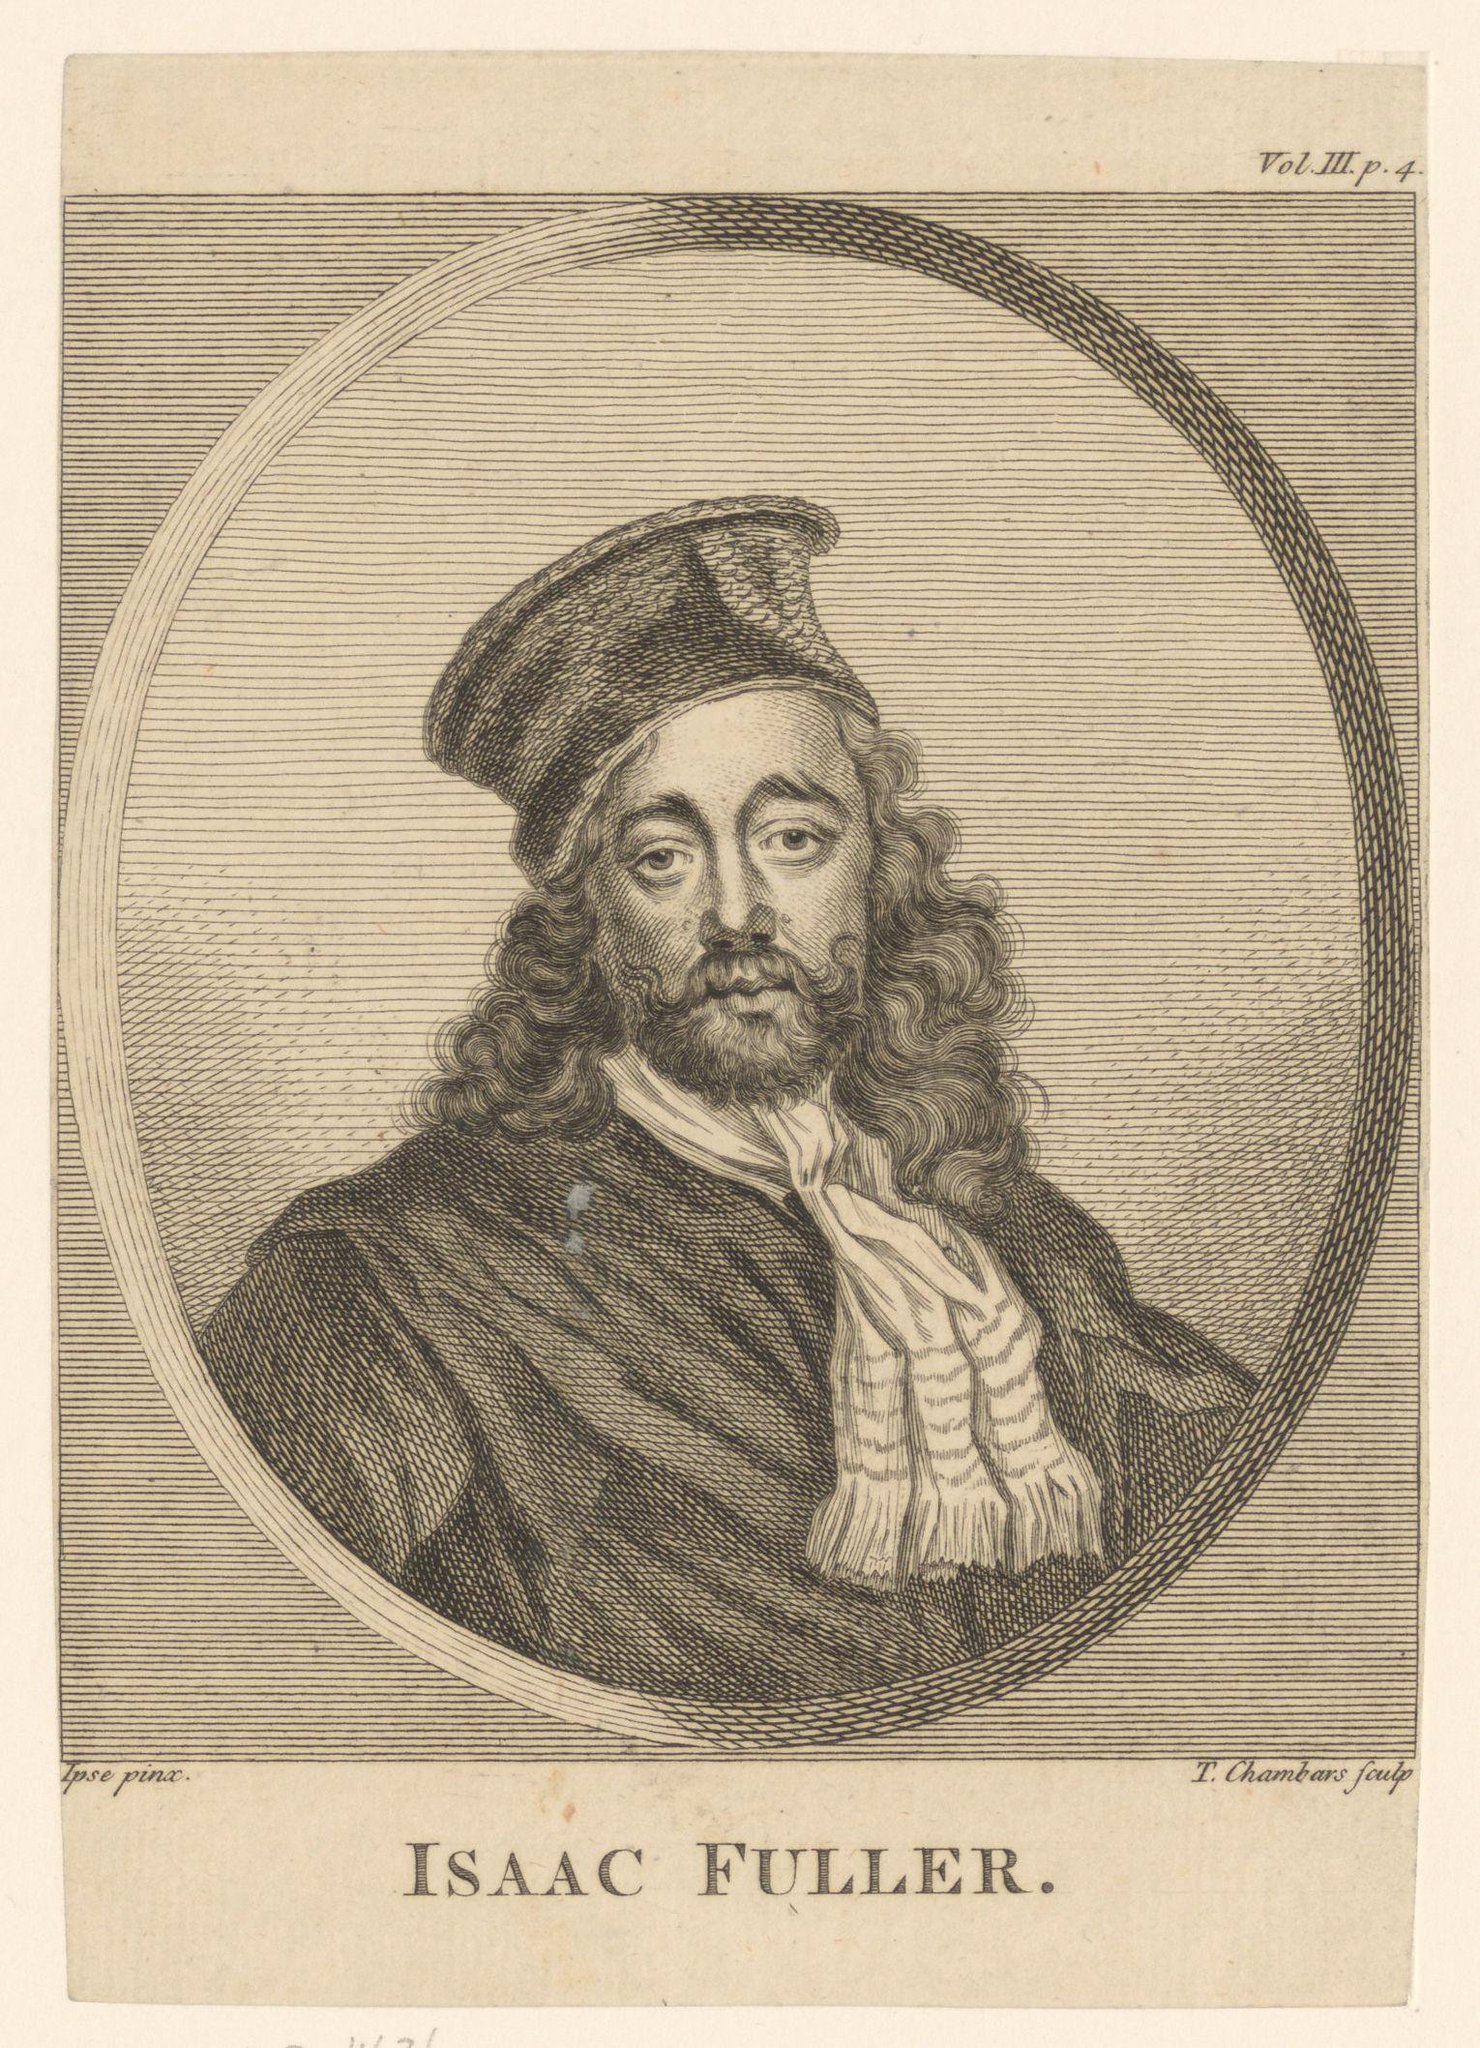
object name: print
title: Portret van Isaac Fuller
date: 1734-1762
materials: paper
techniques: engraving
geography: london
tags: london, painter, isaac fuller, historical persons, portrait, self-portrait of painter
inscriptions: collector's mark: Lugt 2228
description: Prent uit: Walpole, Horace. Anecdotes of painting in England : with some account of the principal artists : and incidental notes on other arts; collected by the late Mr. George Vertue : and now digested and published from his original Mss. / by Horace Walpole. 4 dln. Londen: Horace Walpole, [1762-1789], dl. 3, p. 4.